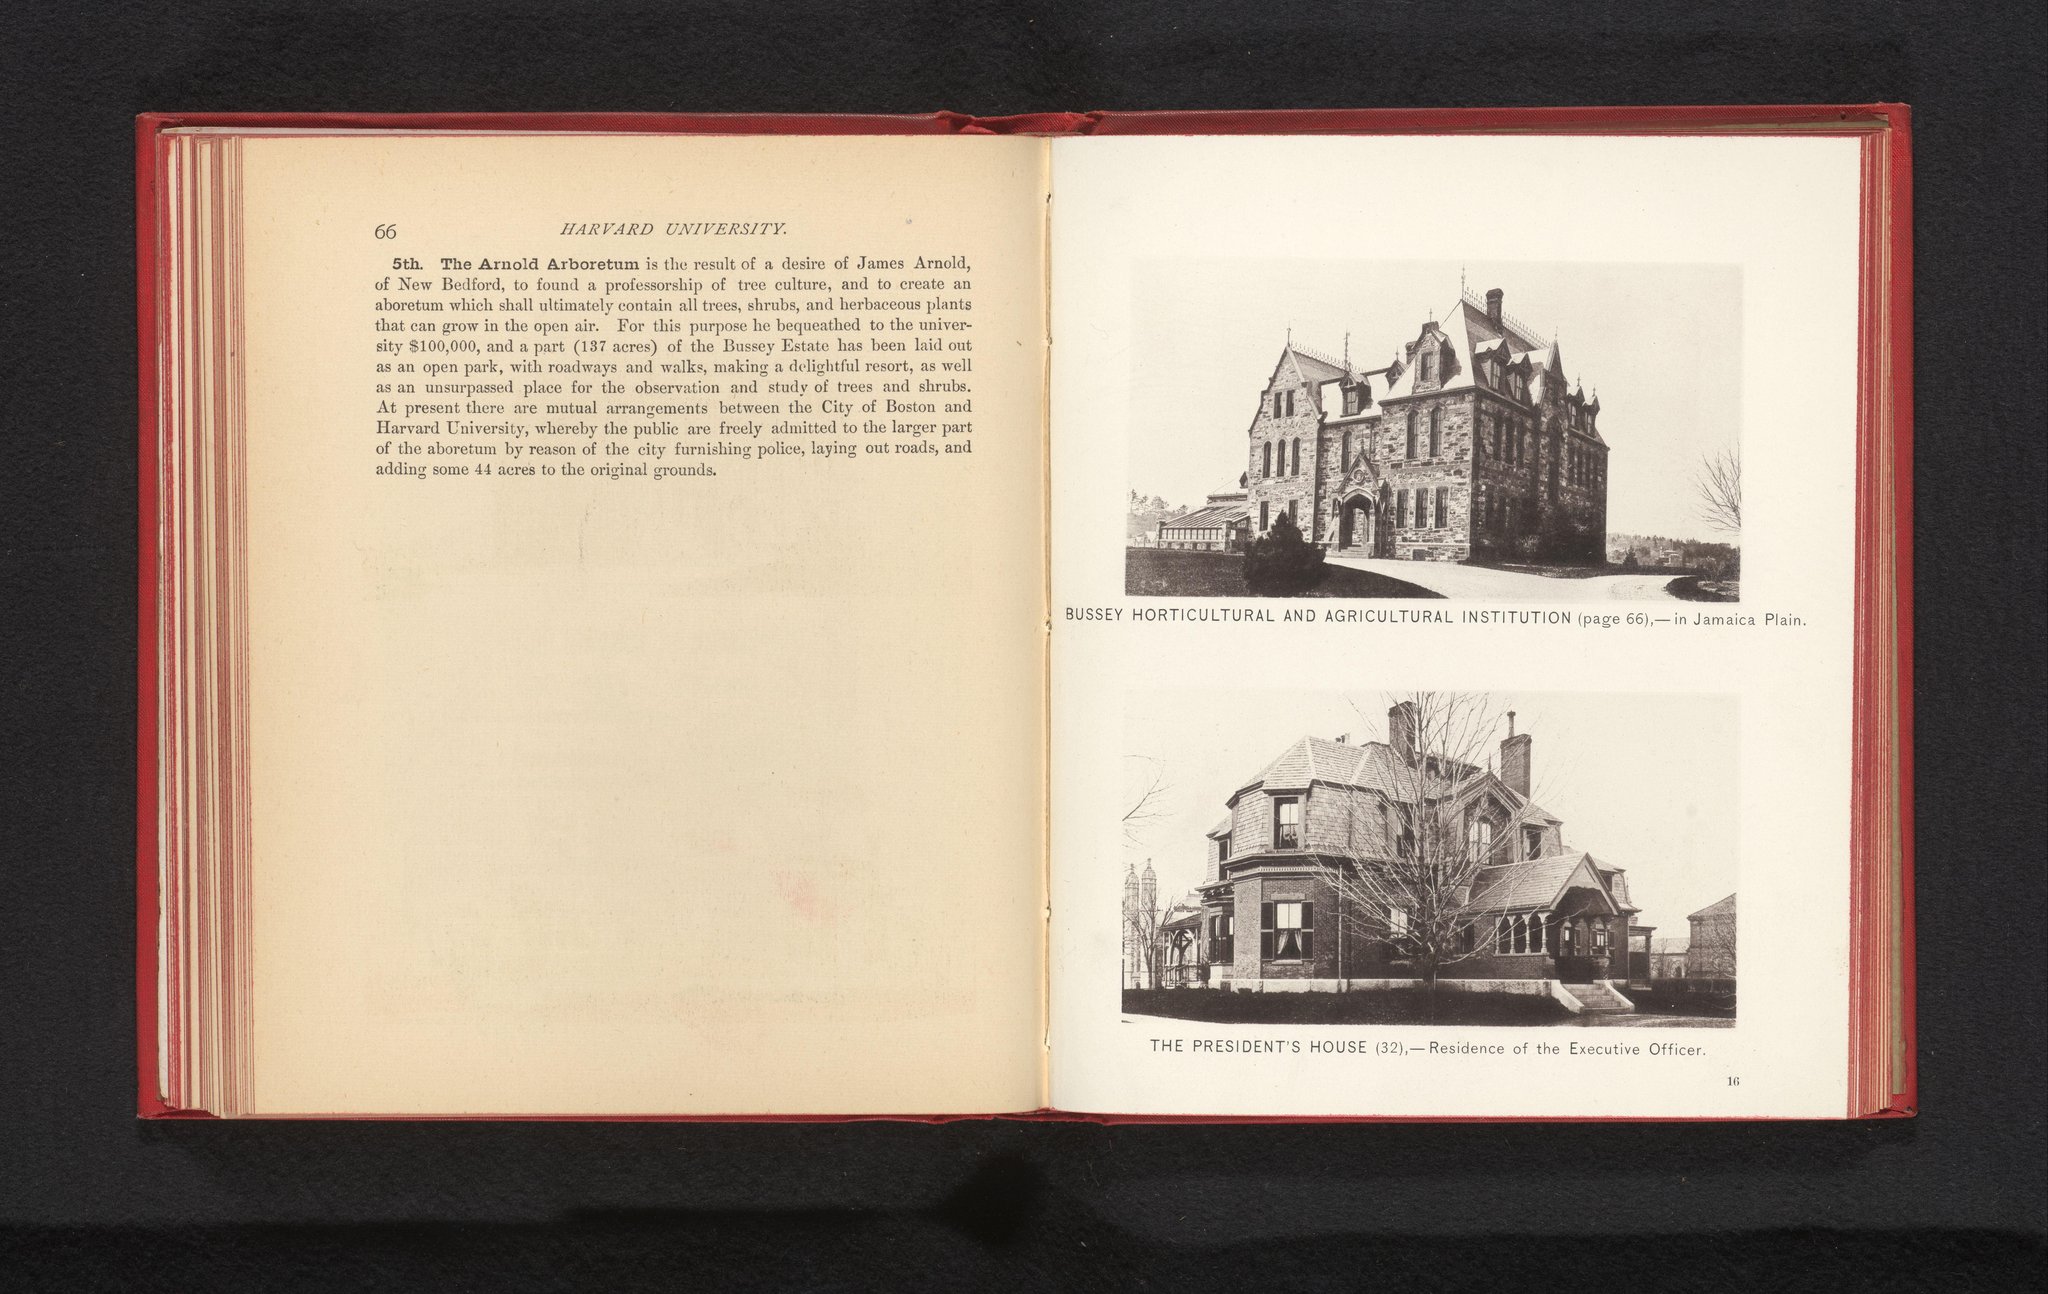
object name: photomechanical print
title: Bussey horticultural and agricultural institution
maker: Anonymous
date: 1881-1886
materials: paper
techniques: photograph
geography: cambridge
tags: university building, college, façade (of house or building)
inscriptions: number: ‘(32)’